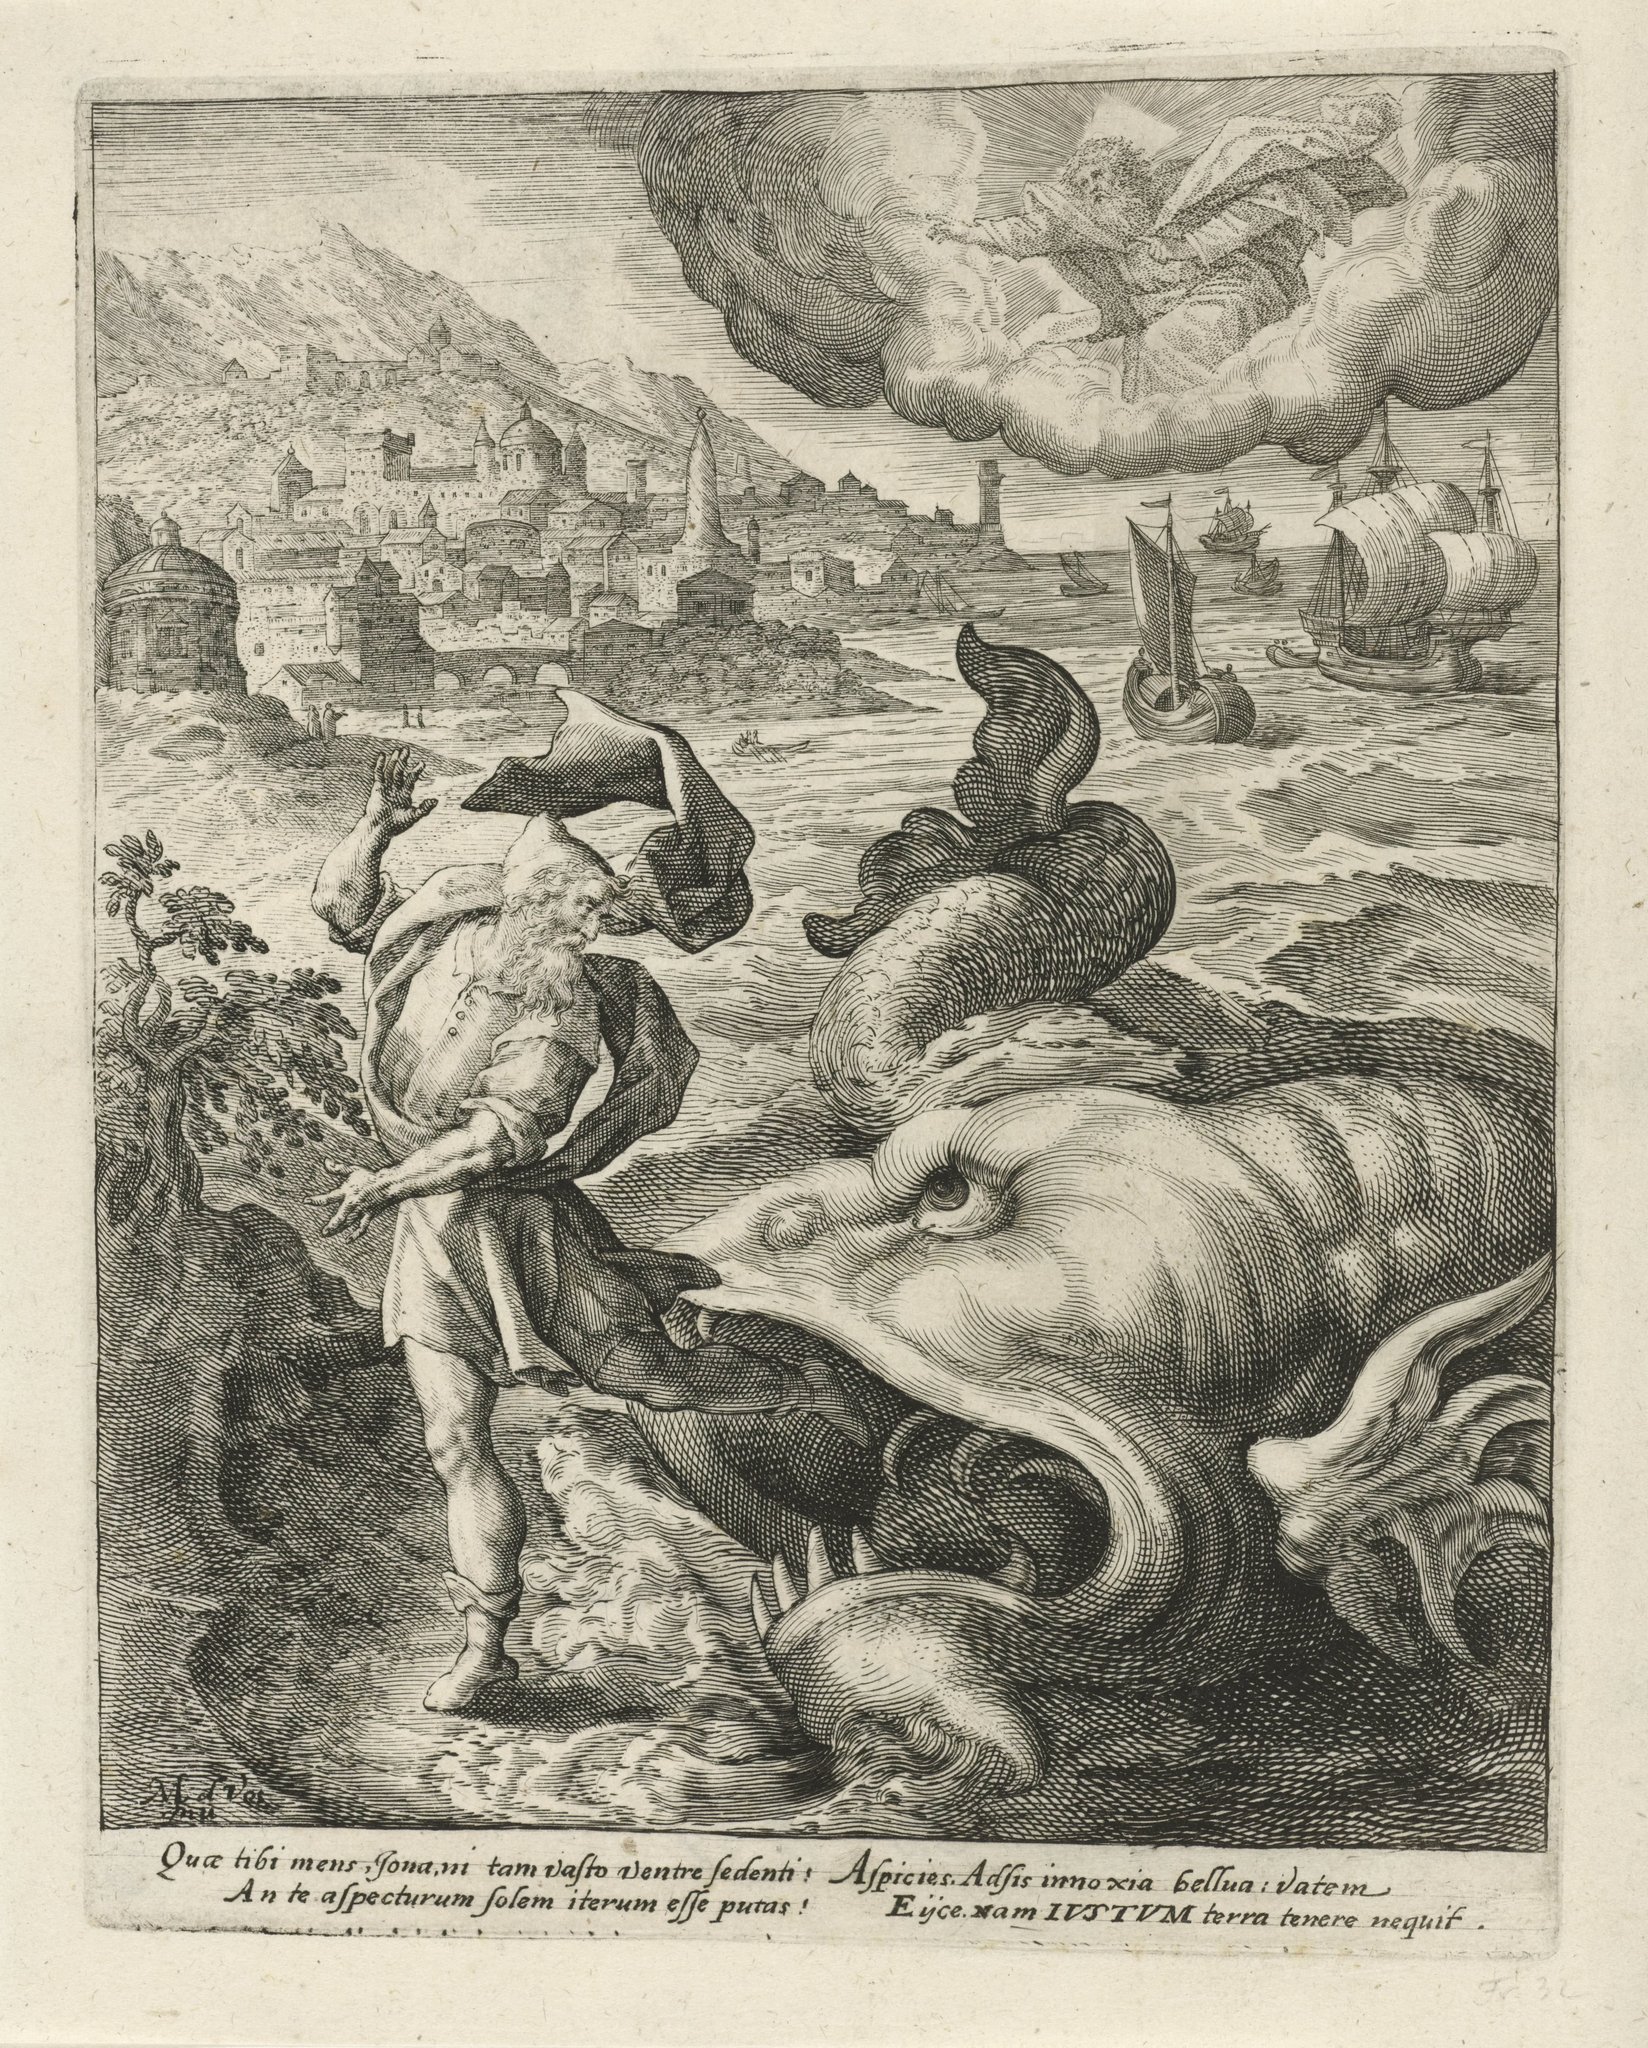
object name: print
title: Geschiedenis van Jona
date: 1574-1637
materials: paper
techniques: engraving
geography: antwerp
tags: after a three-day sojourn in the belly of the monster jonah is cast on dry land; jonah may be shown nude and bald-headed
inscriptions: collector's mark: Lugt 2228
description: Na drie dagen en nachten in de buik van de vis overleefd te hebben spuwt de vis Jona uit op het land. God kijkt naar Jona vanuit een wolk. Het water op zee is rustig. In de marge een tweeregelig onderschrift in het Latijn.